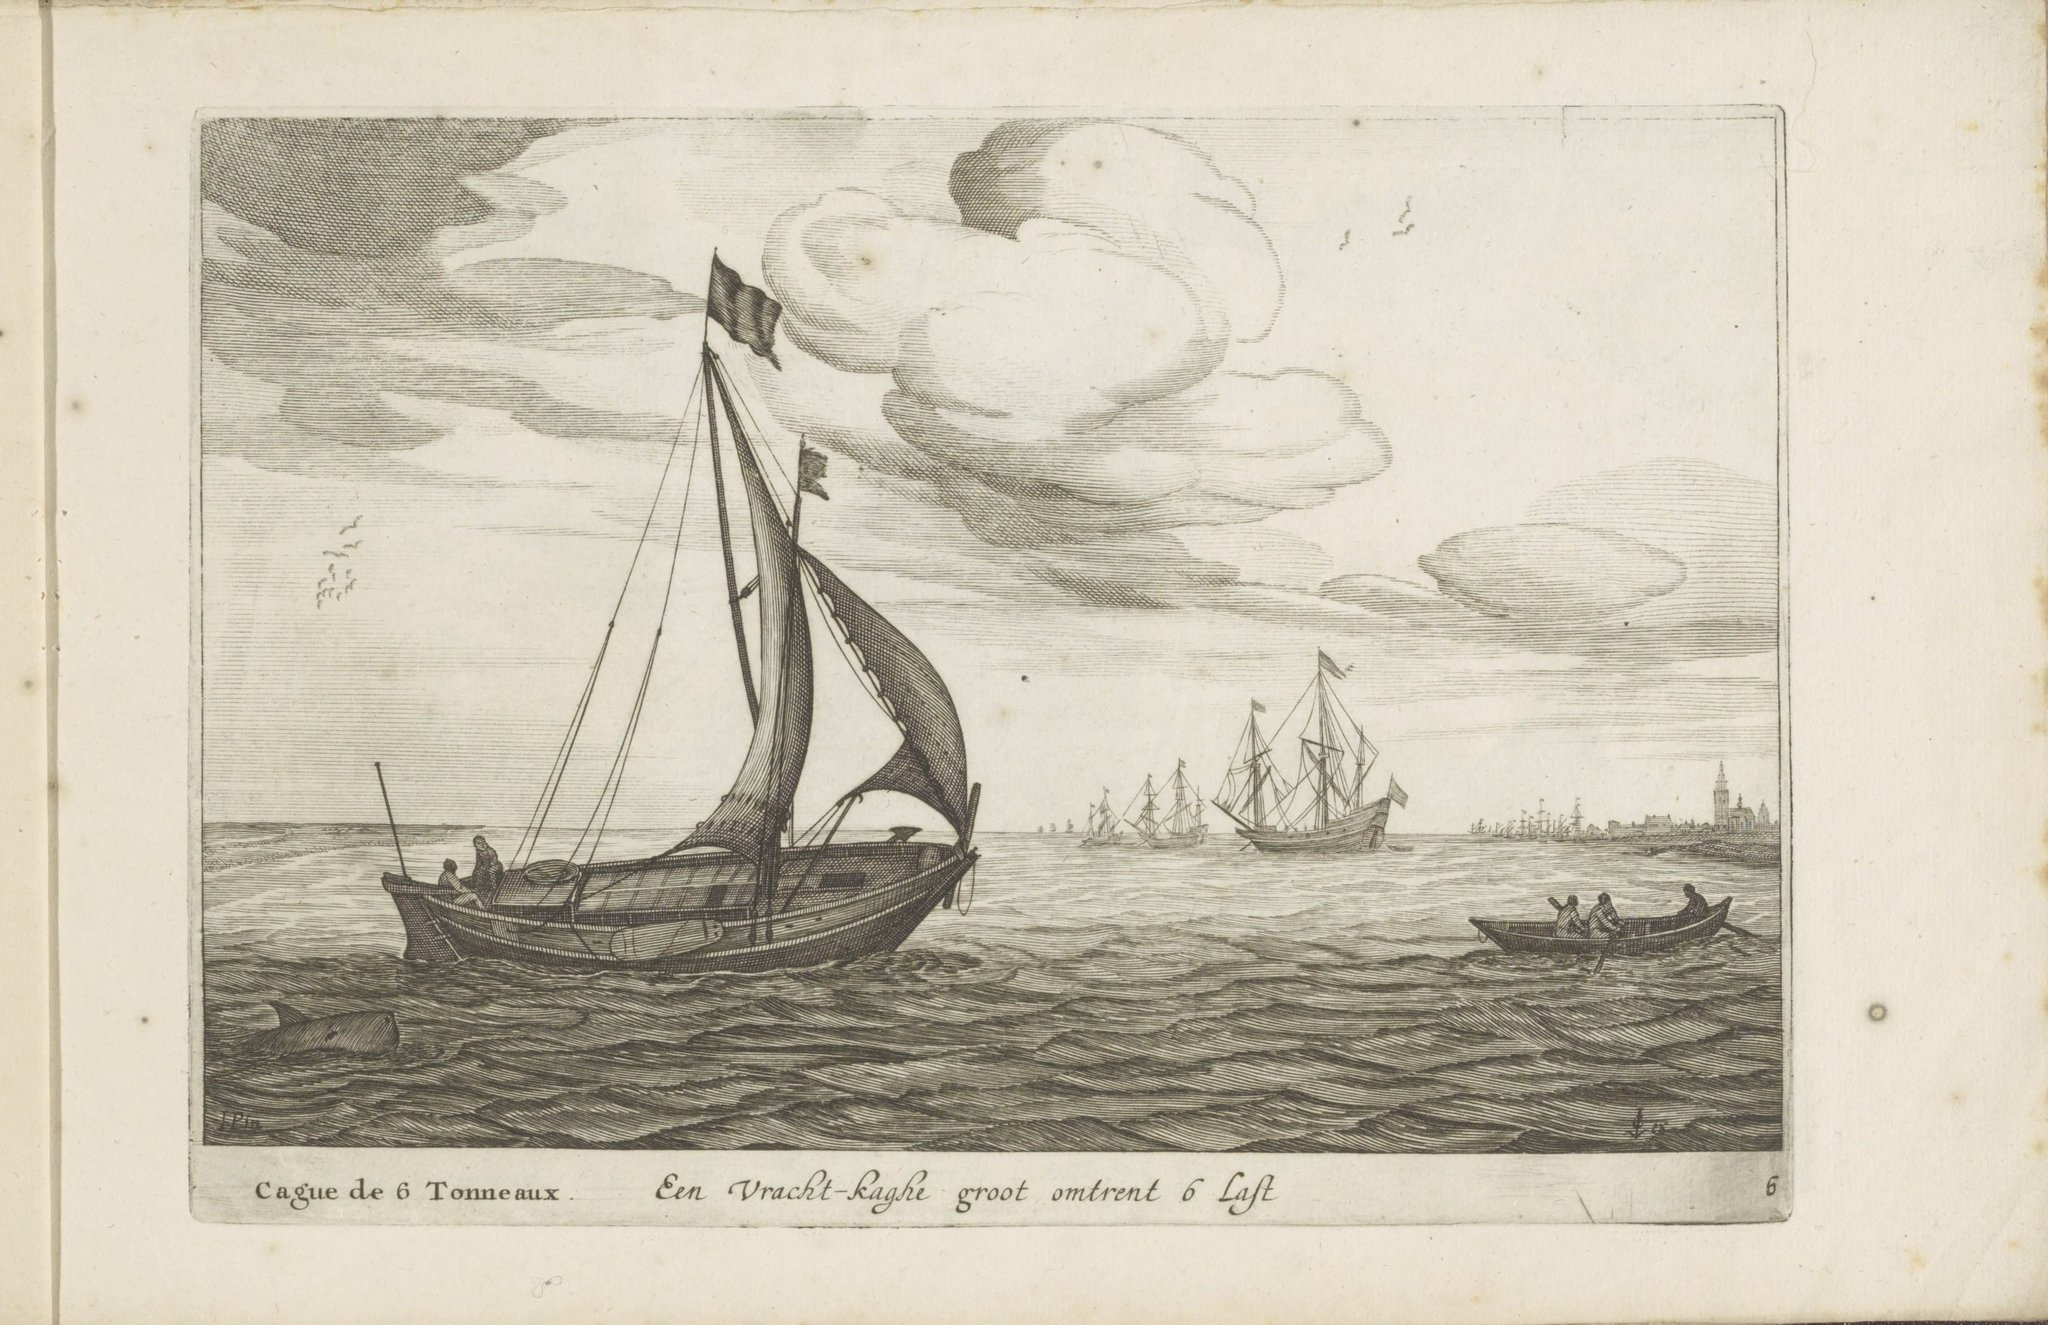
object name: album leaf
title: Een Vracht-kaghe groot omtrent 6 Last / Cague de 6 Tonneaux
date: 1627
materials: paper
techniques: engraving, etching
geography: amsterdam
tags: sailing-ship, sailing-boat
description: Vrachtkagen op het water. De prent maakt deel uit van een album.